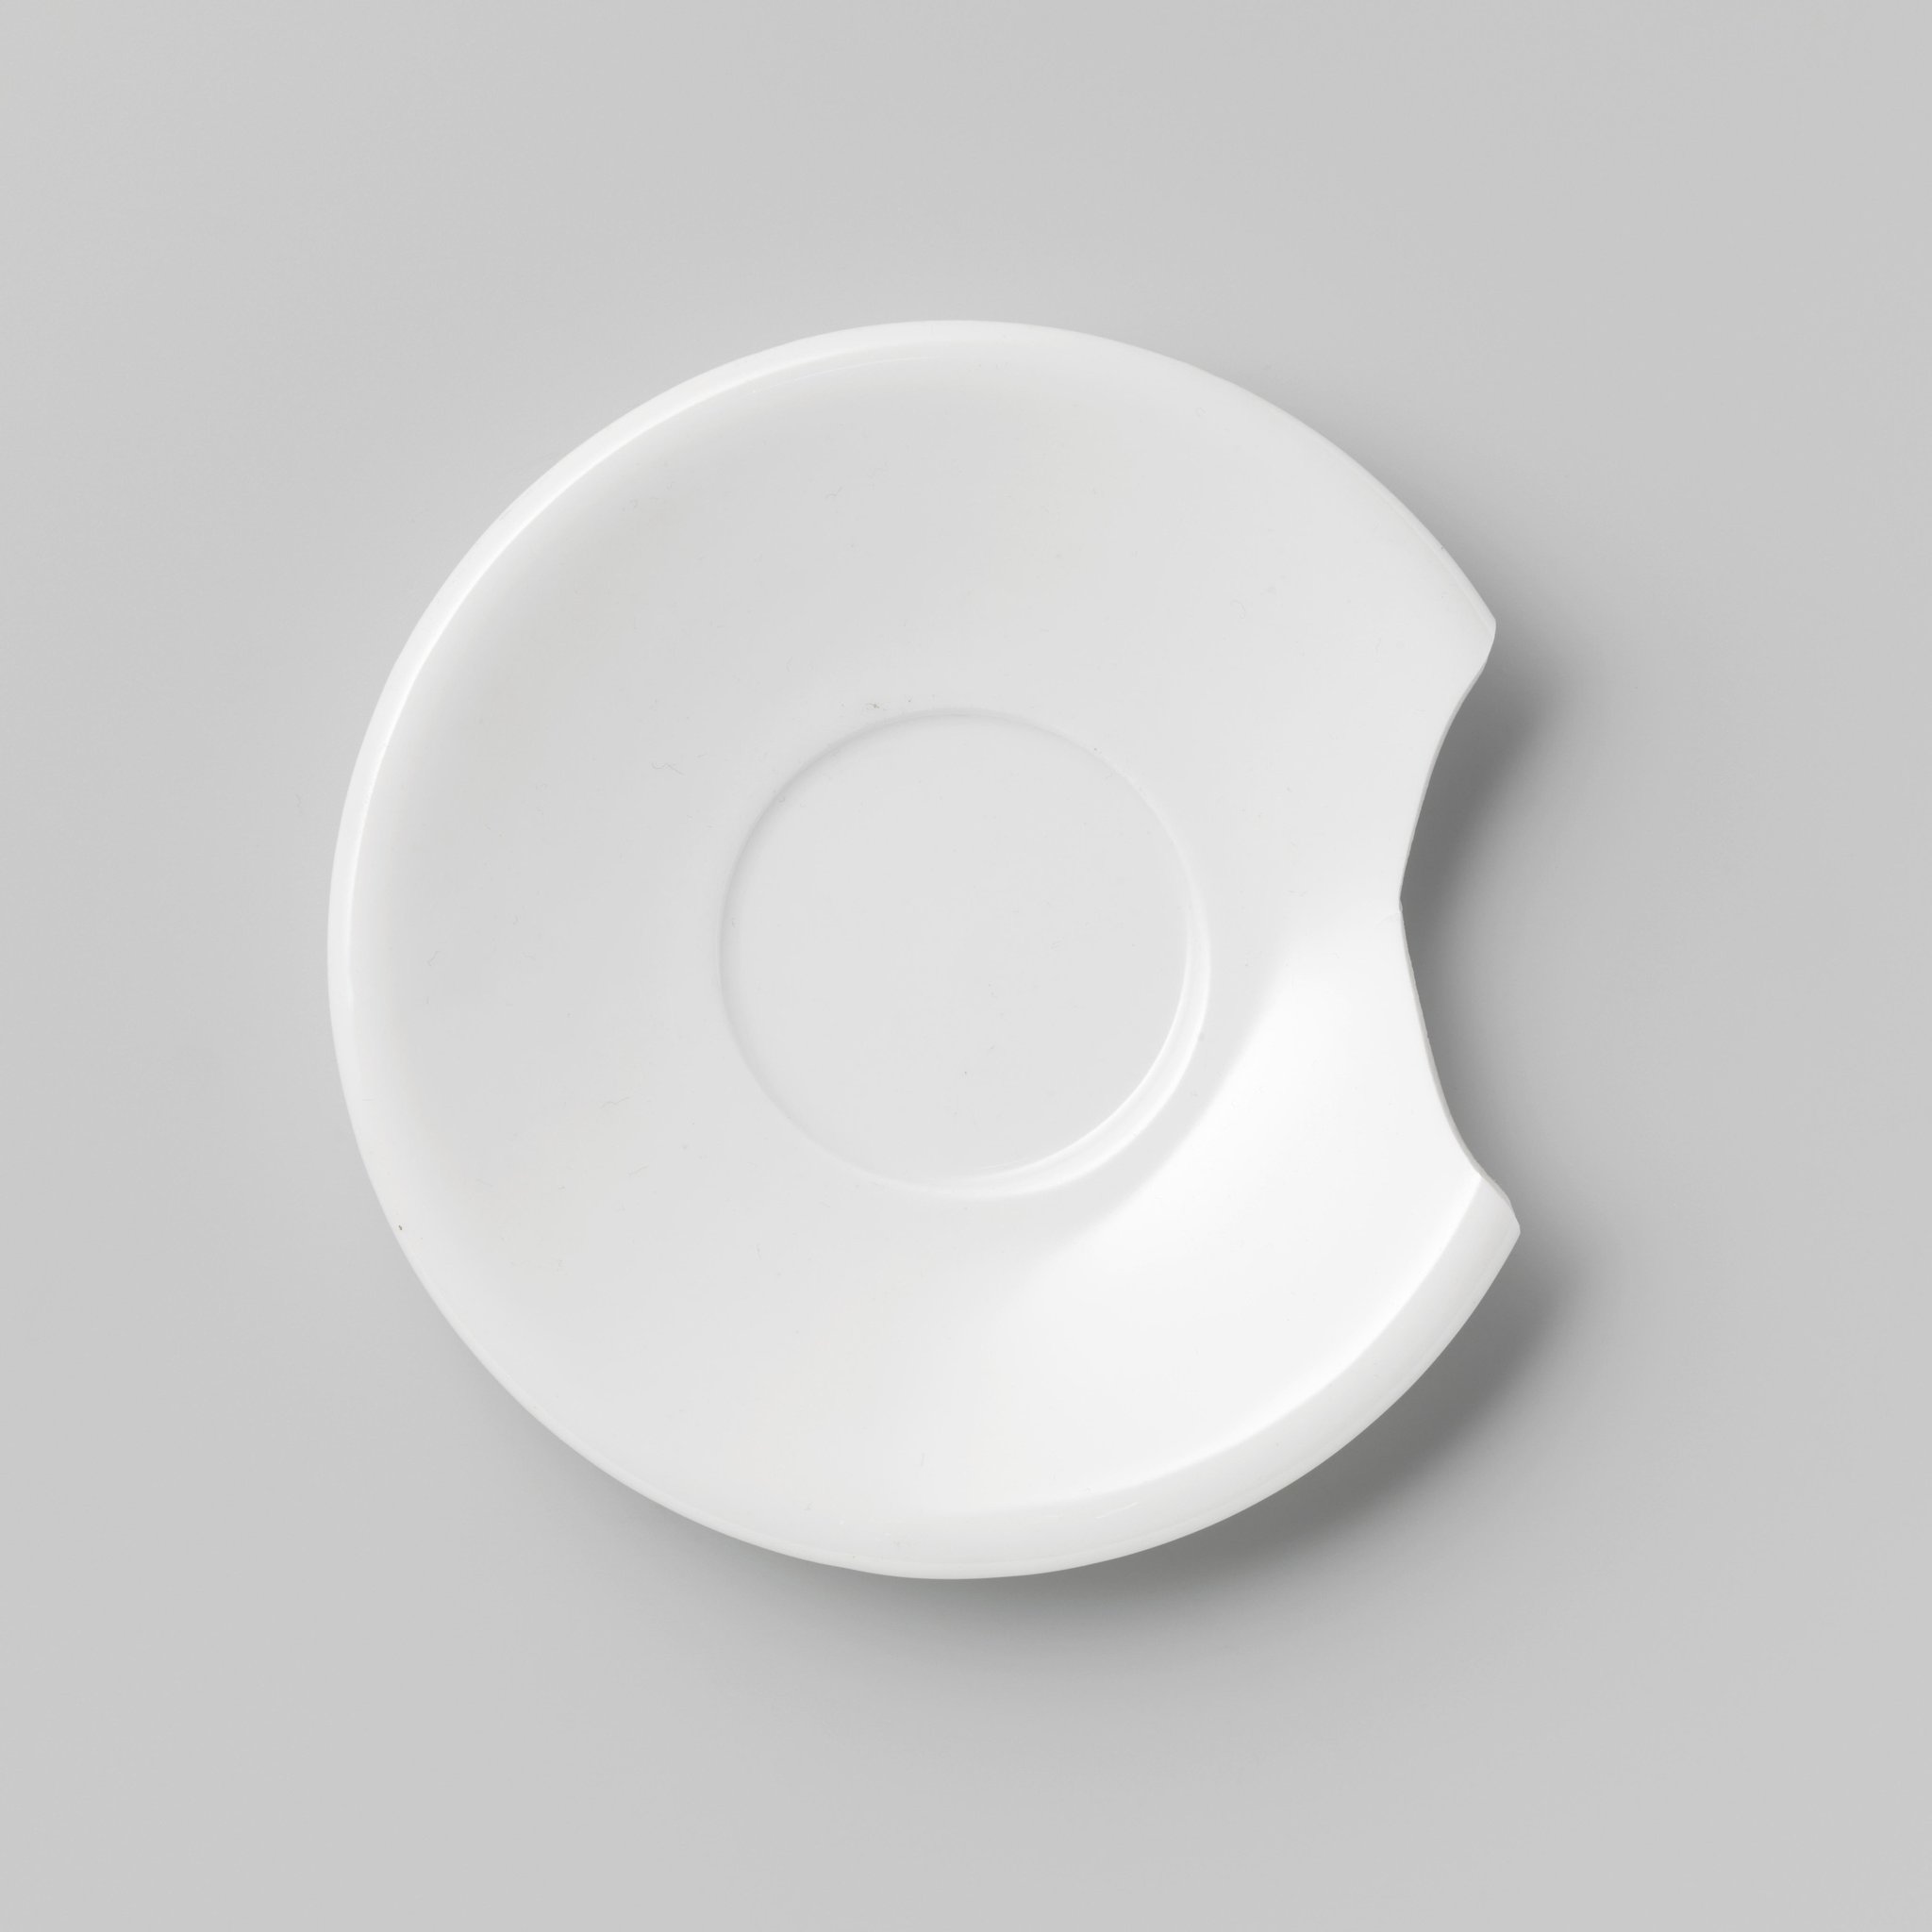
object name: platter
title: White saucer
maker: Anonymous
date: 1790-1800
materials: glaze, porcelain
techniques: firing, forming, turning, vitrification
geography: france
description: Schotel van wit porselein, onversierd. Opmerking: stuk uit rand.